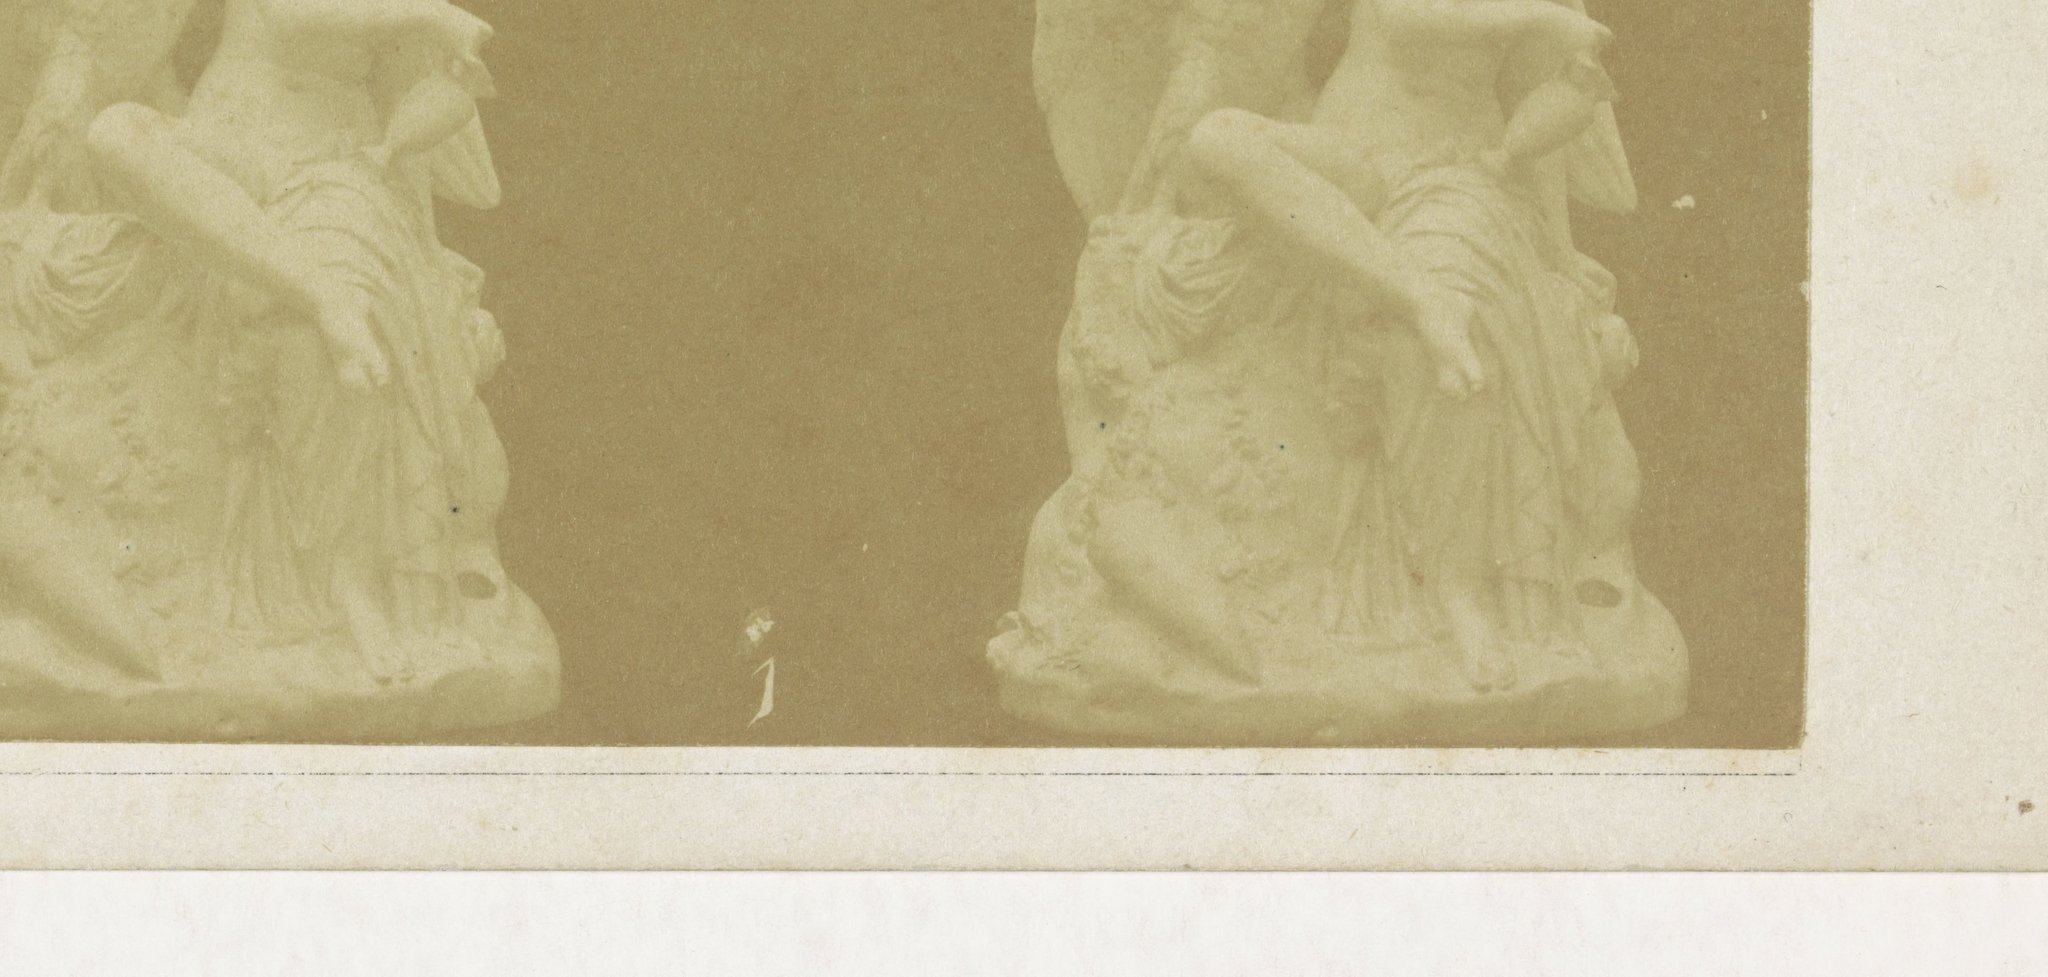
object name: stereograph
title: Sculptuur van een vrouw en een adelaar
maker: Anonymous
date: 1855-1865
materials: cardboard, paper, photographic support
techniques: albumen print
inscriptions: number: ‘90’, number: ‘E4 (?)’, signature: ‘Yael (?)’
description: Midden onder op de foto staat het getal 1.